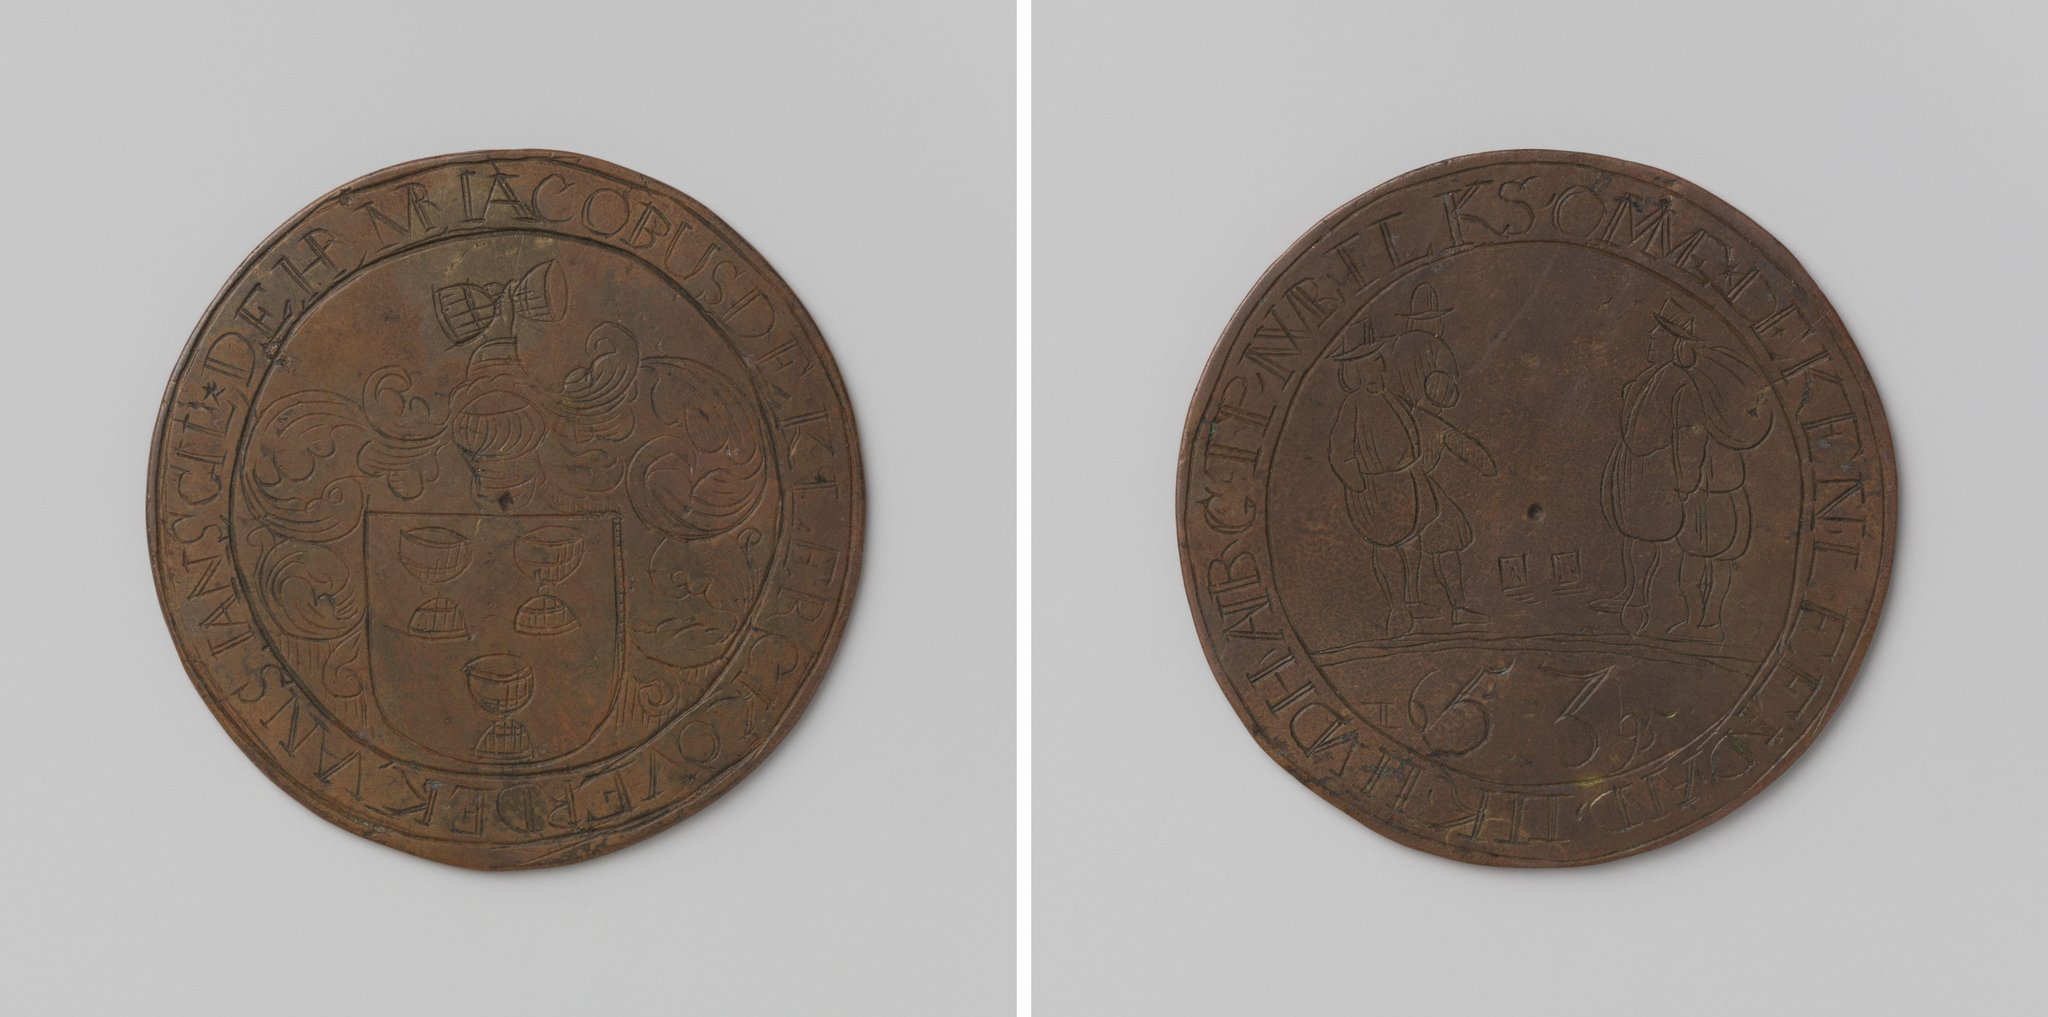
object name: medal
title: St. Jansgilde van Zierikzee, gildepenning met no. 53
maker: Anonymous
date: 1695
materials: brass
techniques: engraving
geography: zierikzee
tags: jacobus de klerck, zierikzee